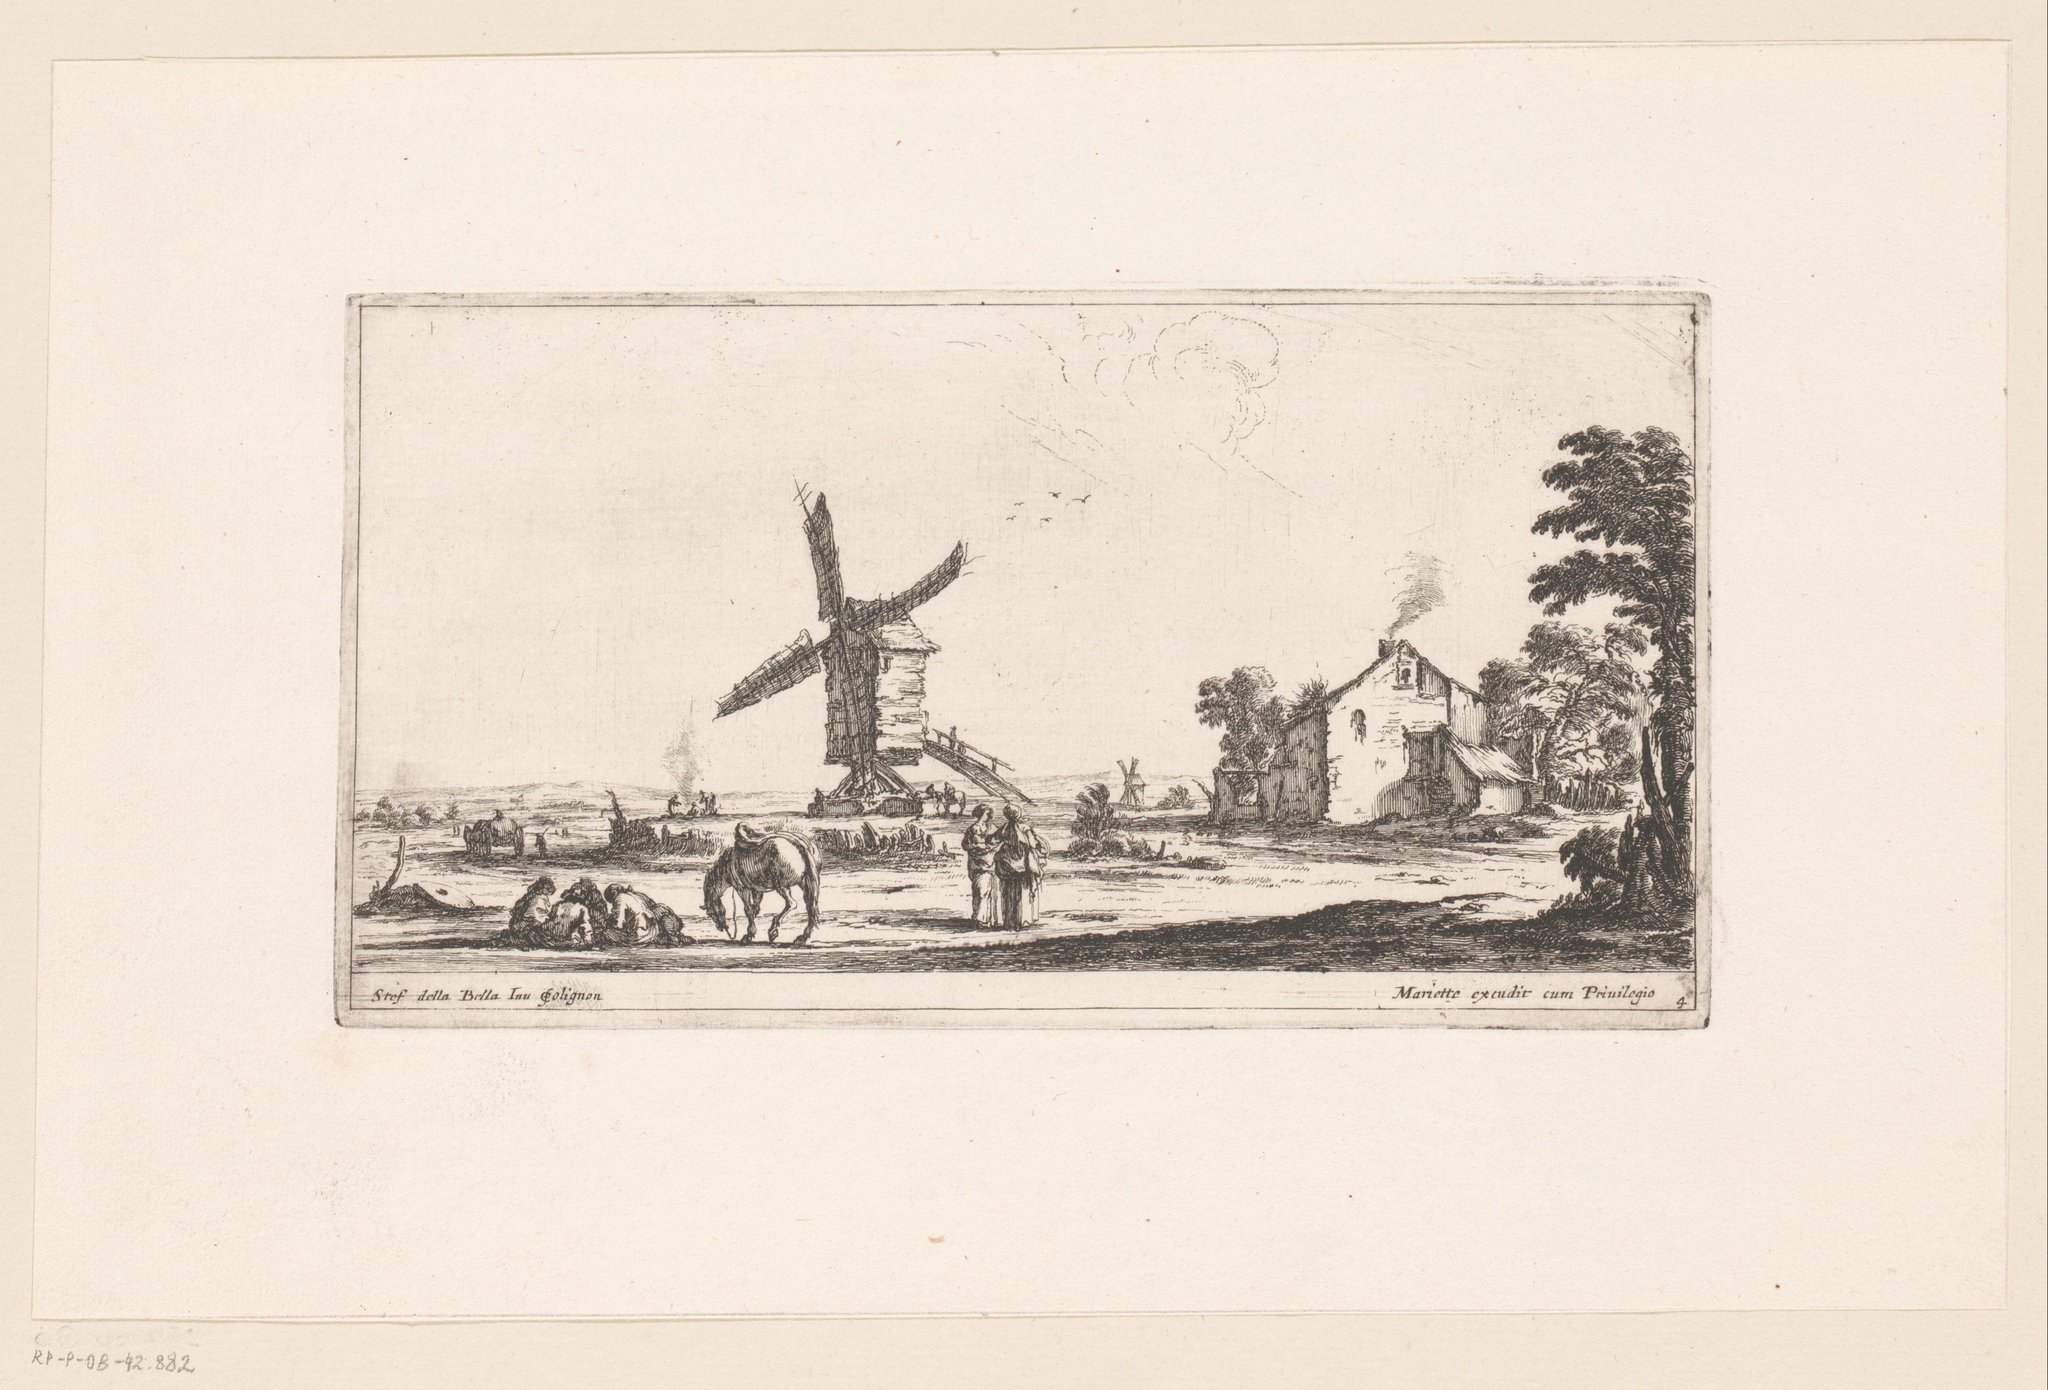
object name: print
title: Landschap met rustende figuren aan een molen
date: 1643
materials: paper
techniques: etching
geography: italy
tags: windmill in landscape, horse, resting - bb - out of doors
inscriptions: collector's mark: Lugt 240